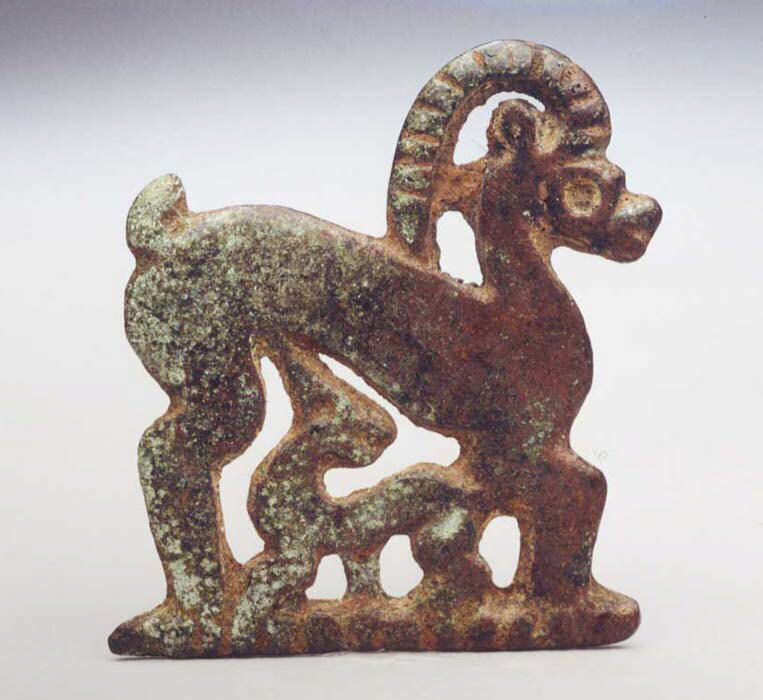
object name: garment plaque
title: Plaque with Ibex and Kid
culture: north chinese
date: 500-301 BCE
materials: bronze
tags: ibex